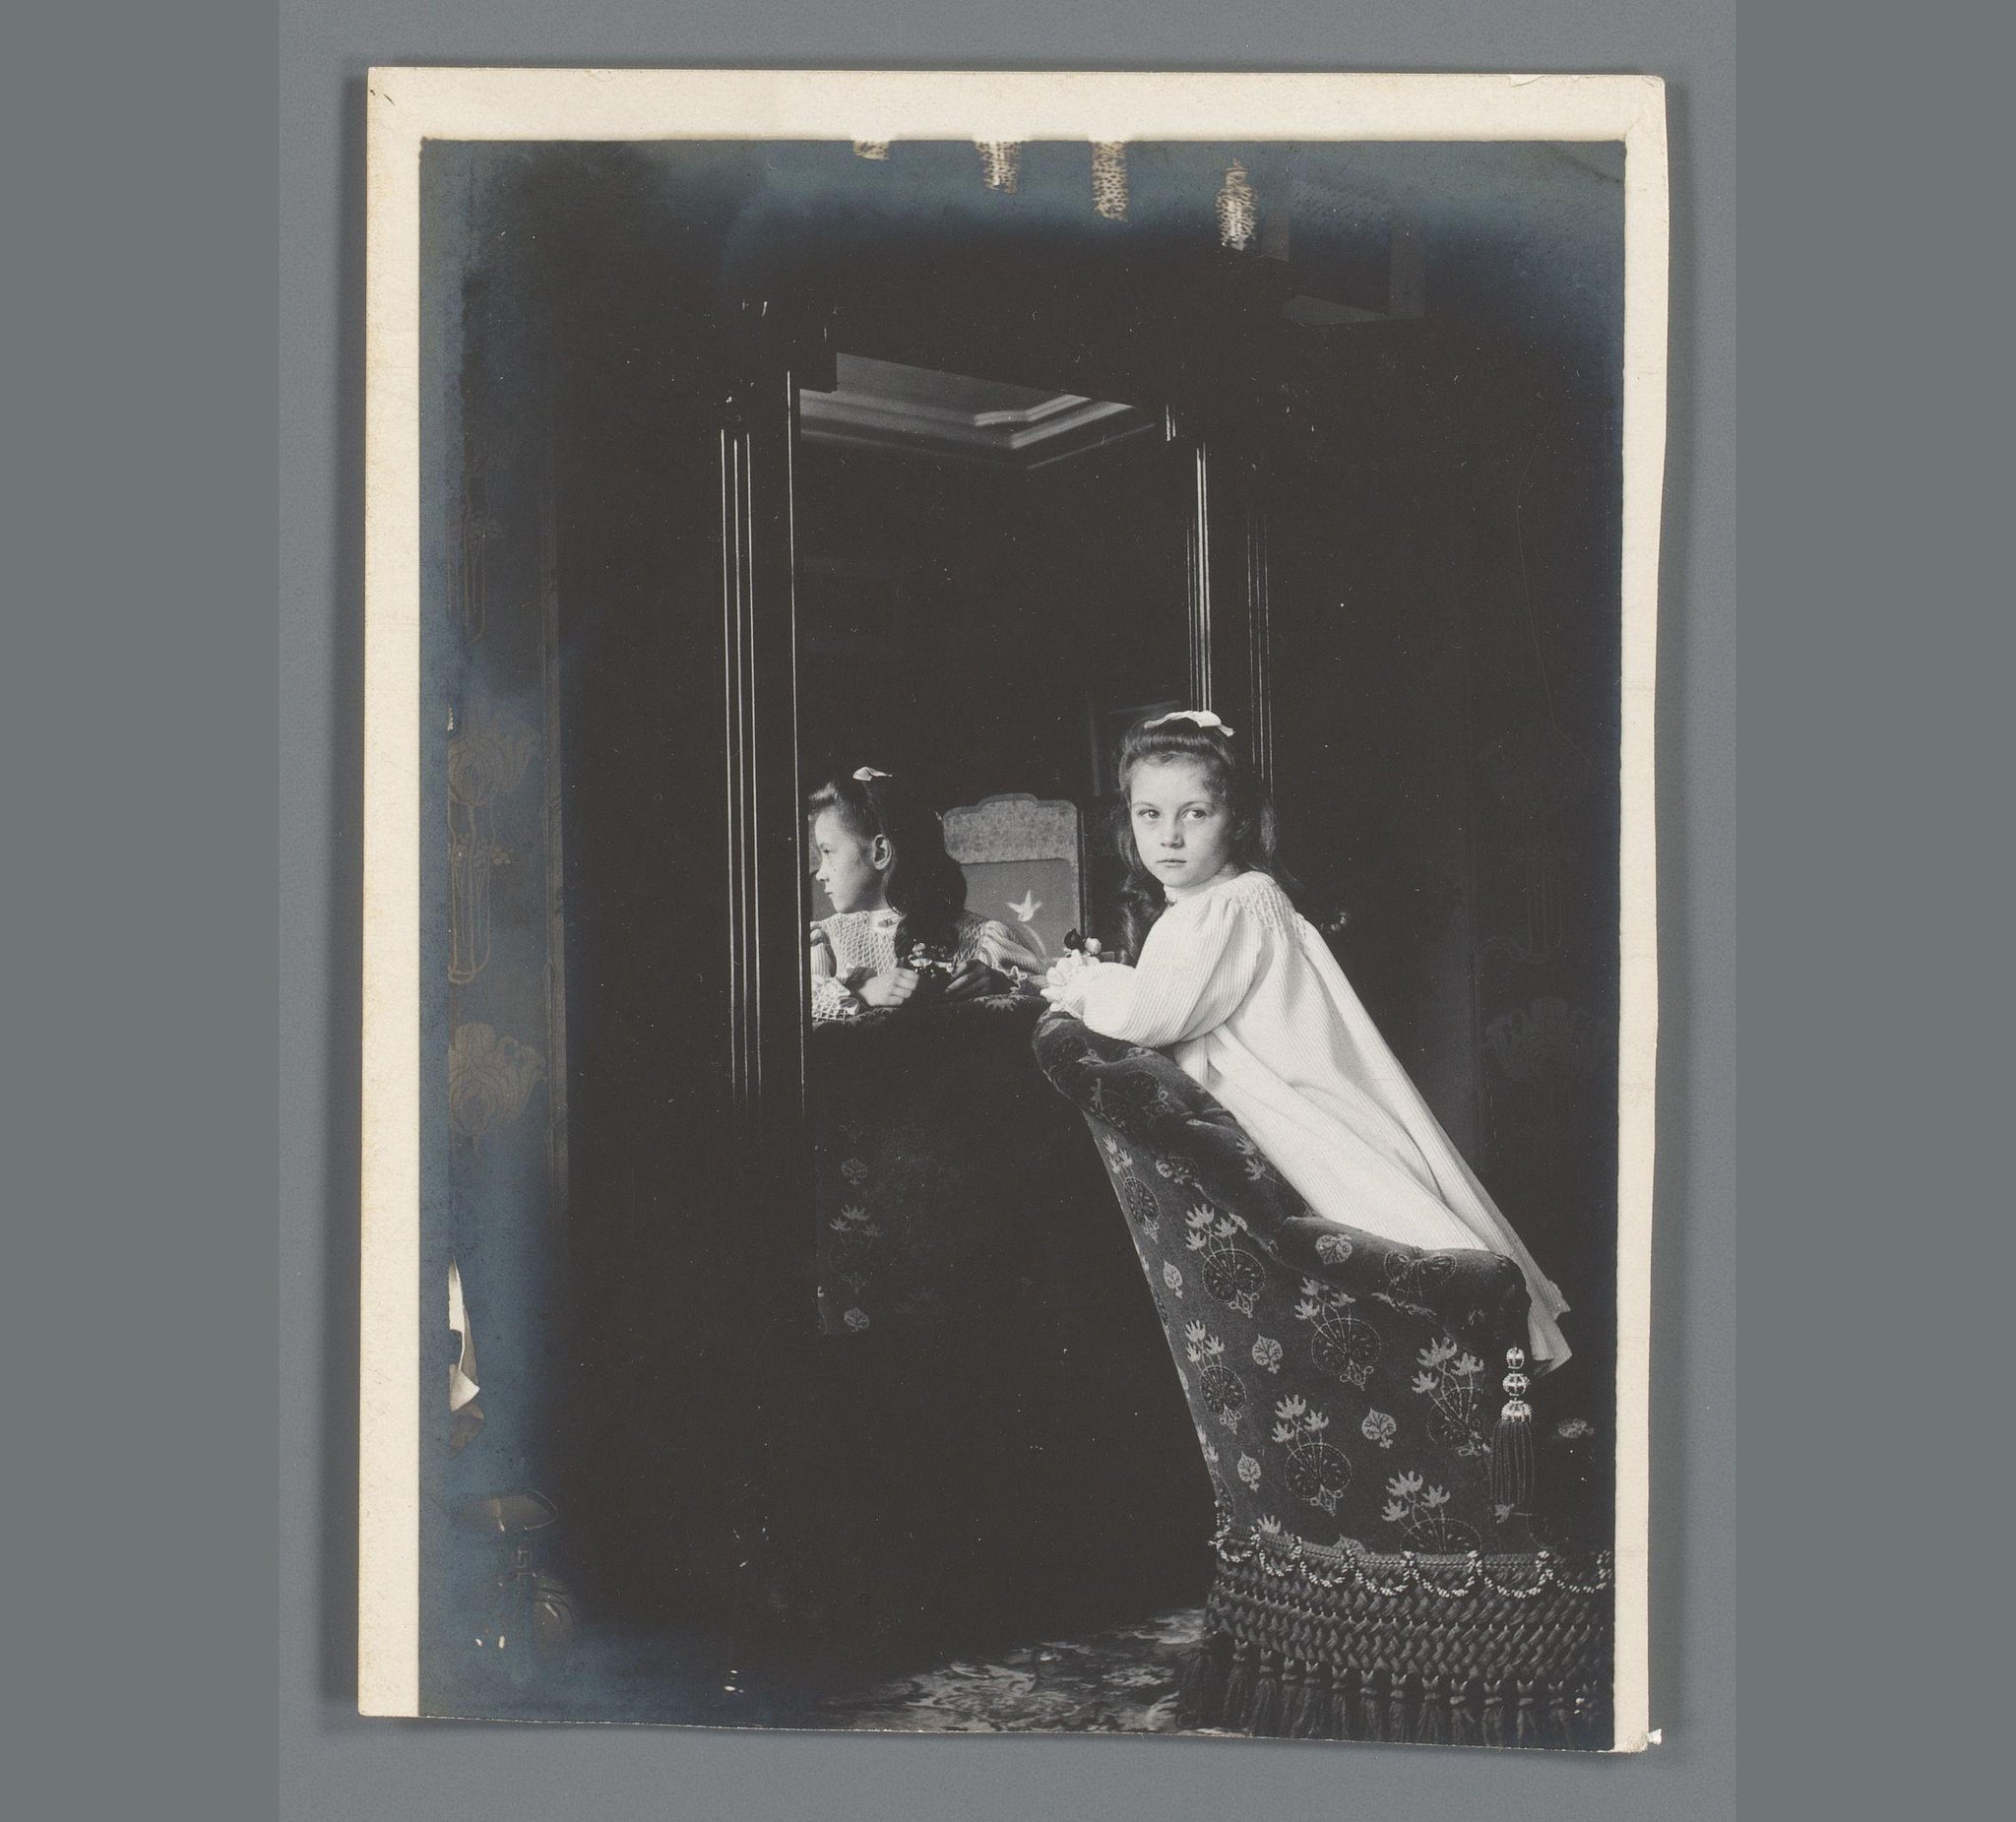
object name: photograph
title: Portret van Johanna (Hans) de Jong zittend voor een spiegel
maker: willem de jong (fotograaf)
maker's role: arts, fotograaf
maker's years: 1864-1918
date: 1900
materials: paper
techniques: gelatin silver print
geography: leiden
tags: johanna petronella lambertina stokhuyzen-de jong (hans), historical persons, girl (child between toddler and youth), reflection (in a mirror) - aa - (for) women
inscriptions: inscription: ‘H’